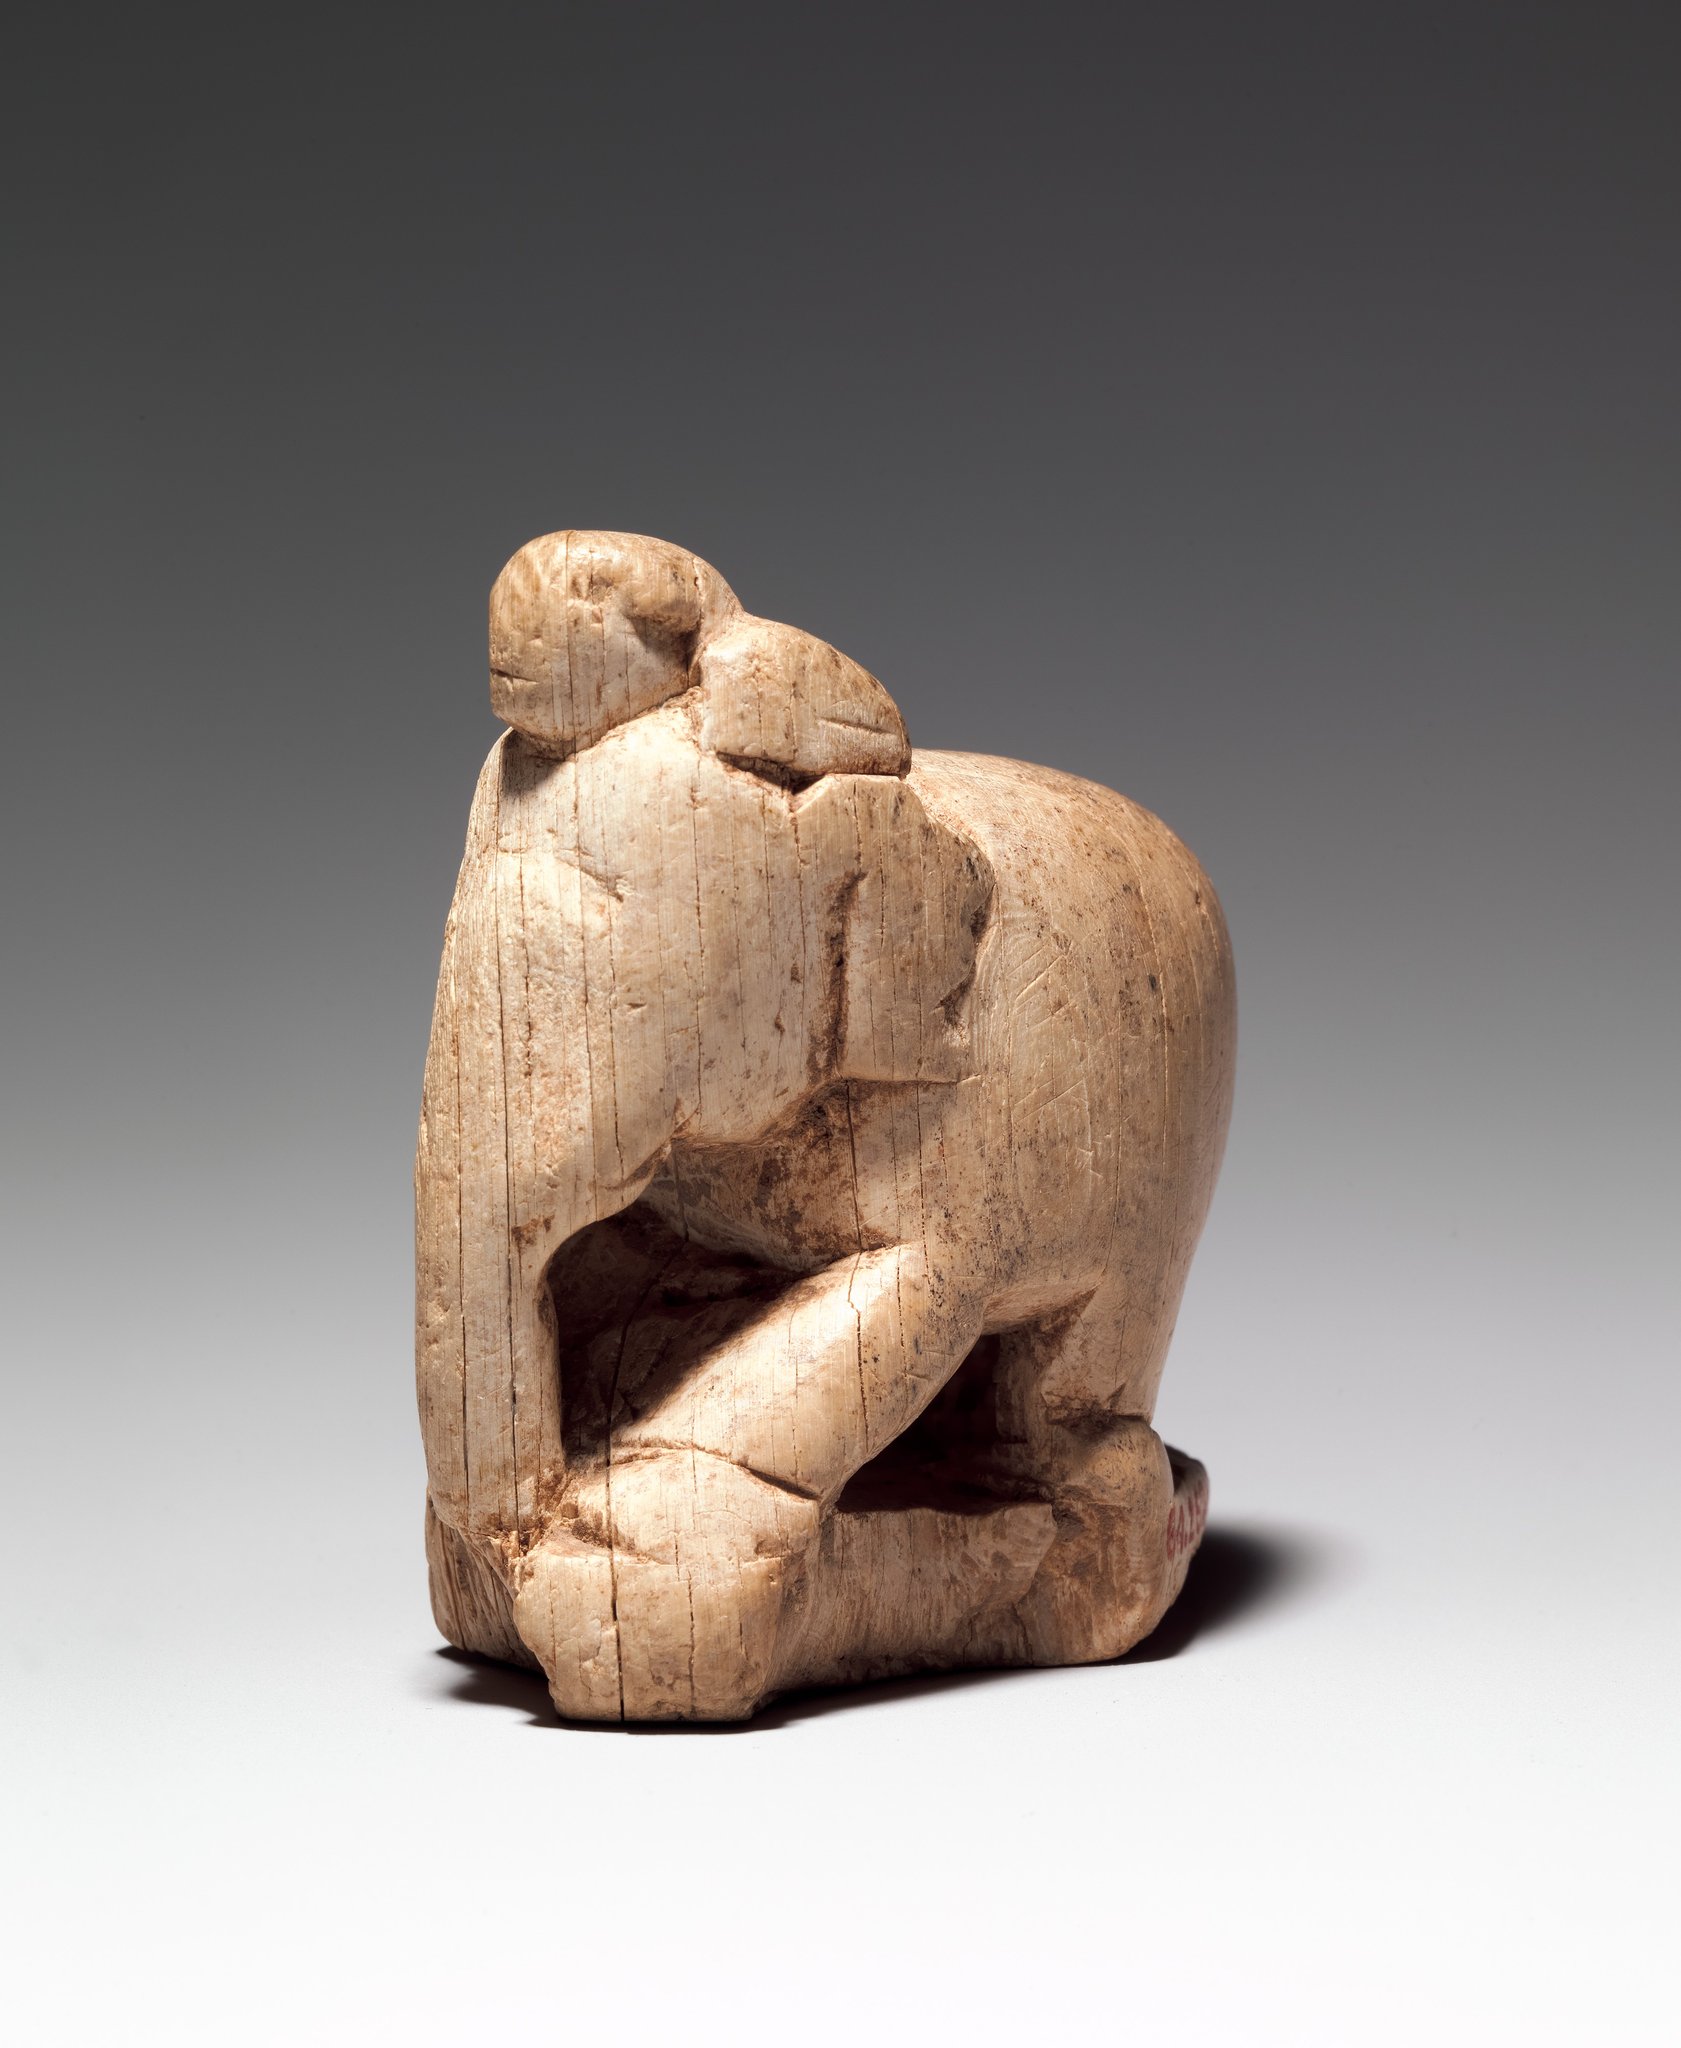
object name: chess piece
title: Chess Piece, Bishop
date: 601-800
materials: ivory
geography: western islamic lands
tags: chess